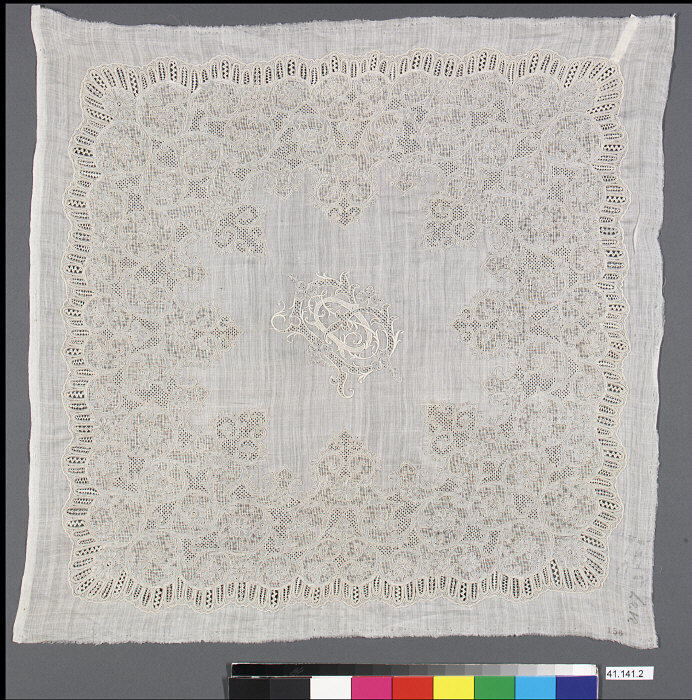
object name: handkerchief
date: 1867-1900